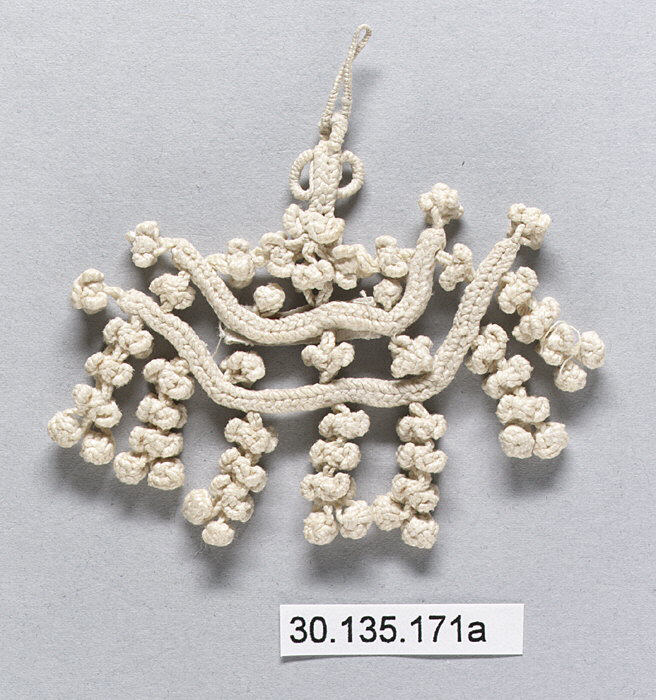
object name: tassel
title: Tassels (3)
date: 1601-1700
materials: linen